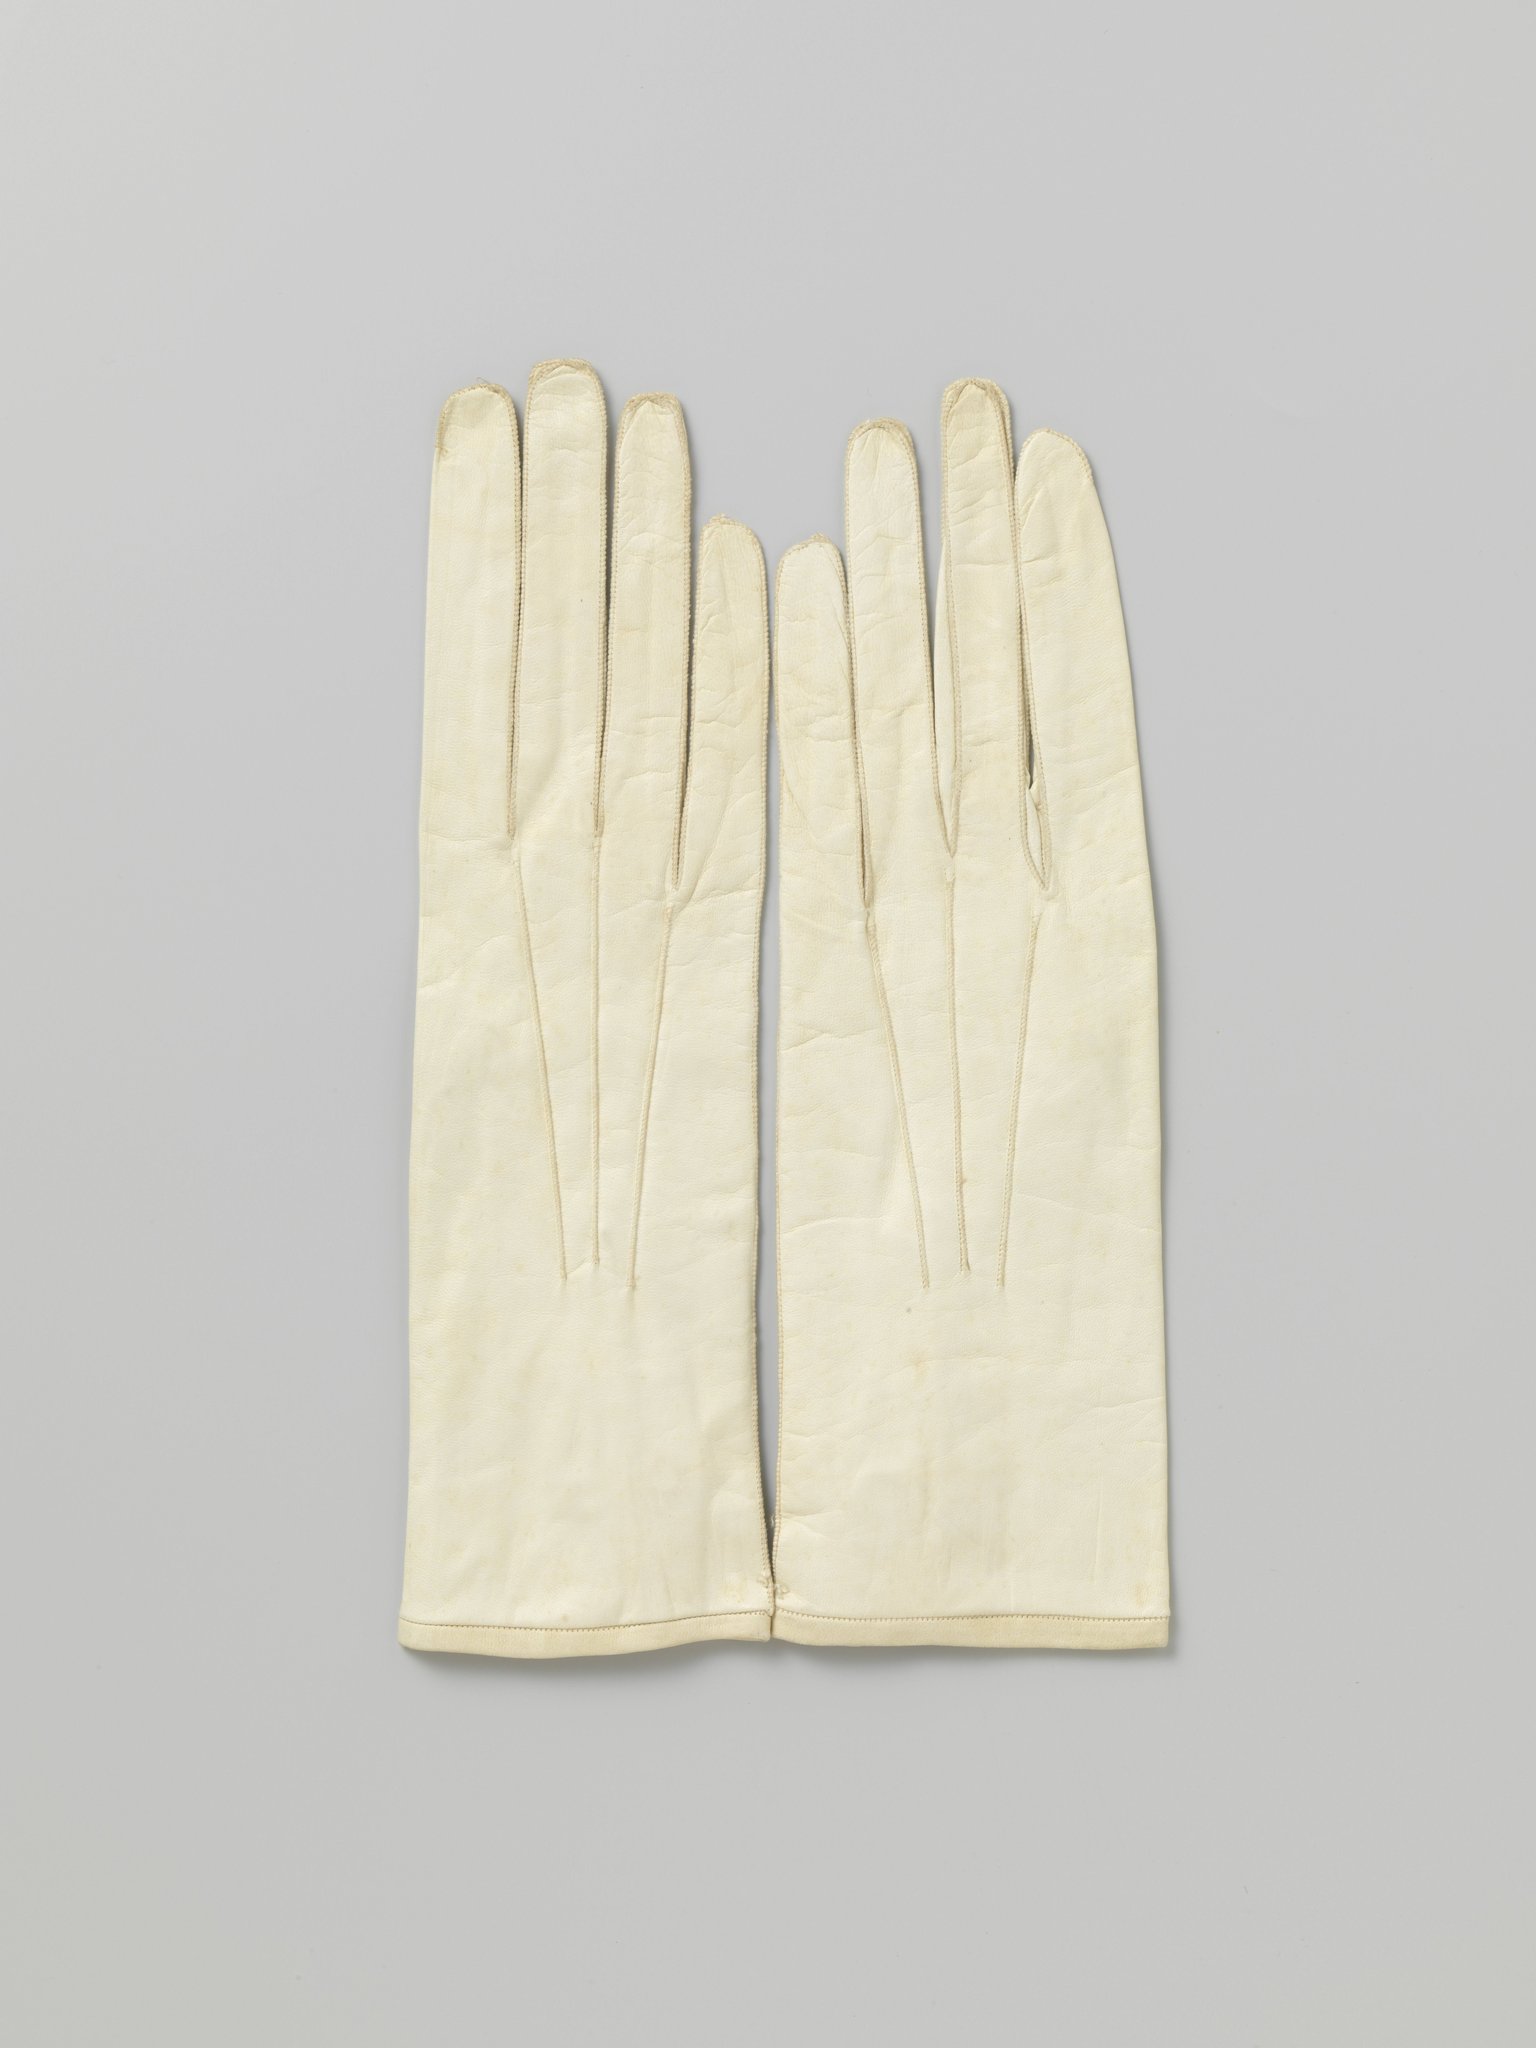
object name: glove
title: Visitehandschoen van wit glacéleer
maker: Anonymous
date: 1900-1925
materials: plastic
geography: western europe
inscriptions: stamp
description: Paar heren-visitehandschoenen van wit glacé leer. Model Kort: Bij het split één drukknoop, met geel benen dopje. Versiering: Op de rug drie uitstralende koordjes, die de peren aanduiden. Maat gedrukt: 8 1/4. Toestand. Winkelnieuw; nog met draadje verbonden. Hetzij nooit gedragen en als voorraad , hetzij wèl gebruikt maar steeds met z'n tweeën in de hand gehouden.